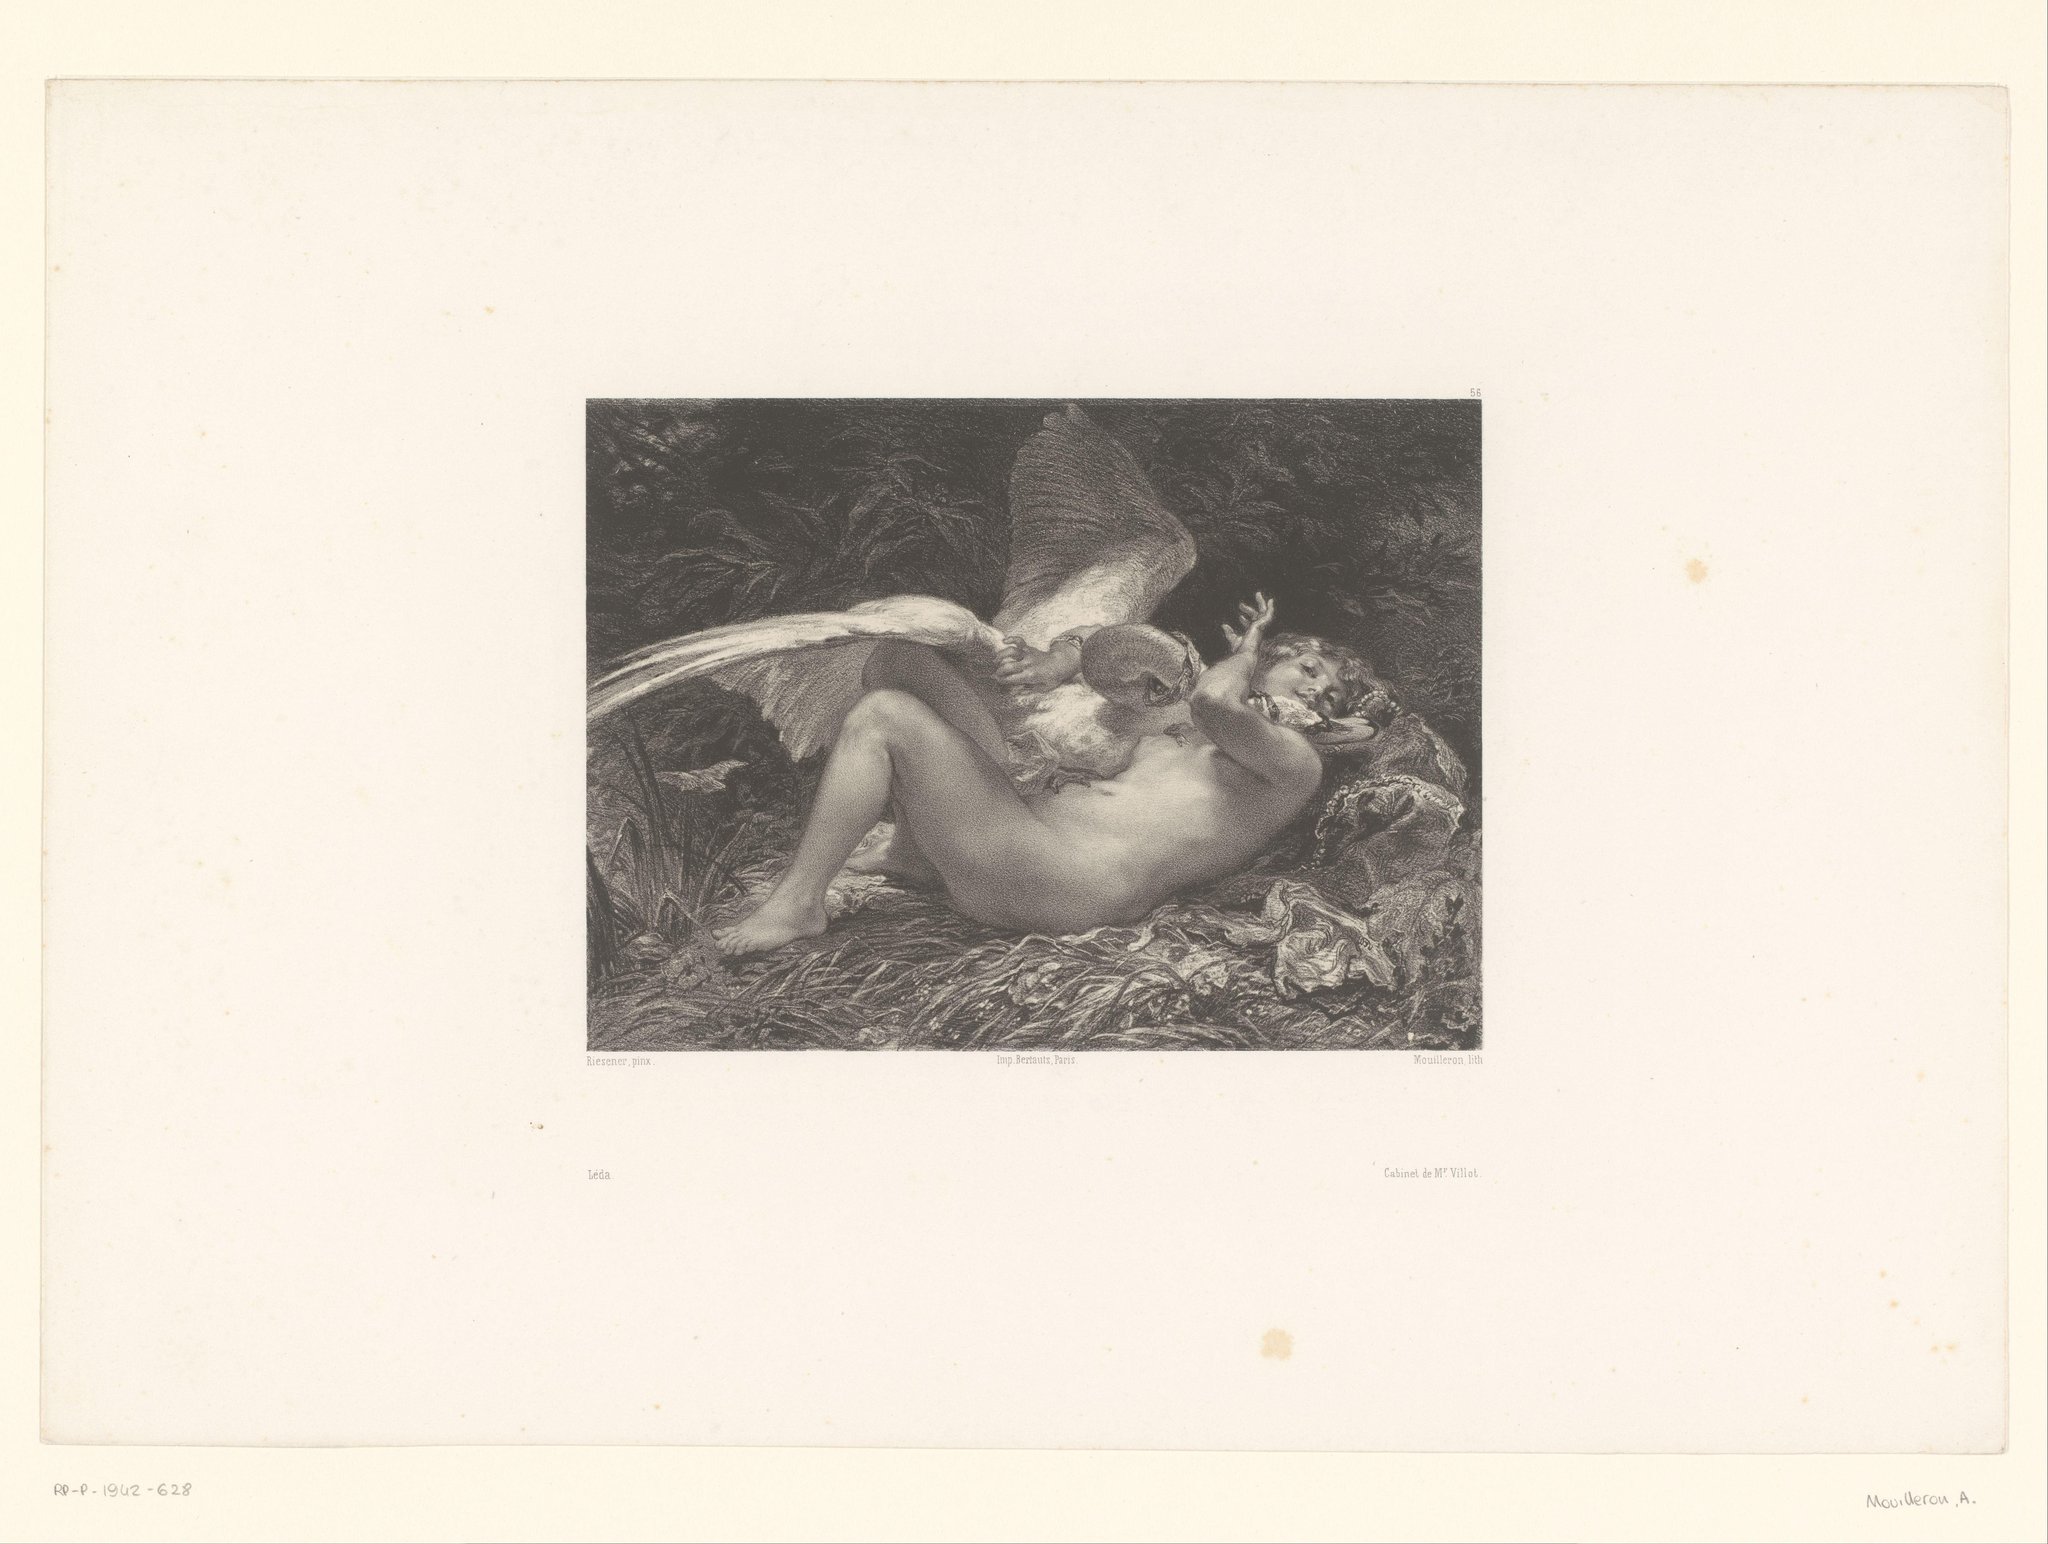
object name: print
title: Oude en hedendaagse kunstenaars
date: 1848-1862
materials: paper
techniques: lithograph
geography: paris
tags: jupiter, in the shape of a swan, and leda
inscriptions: collector's mark: Lugt 2228